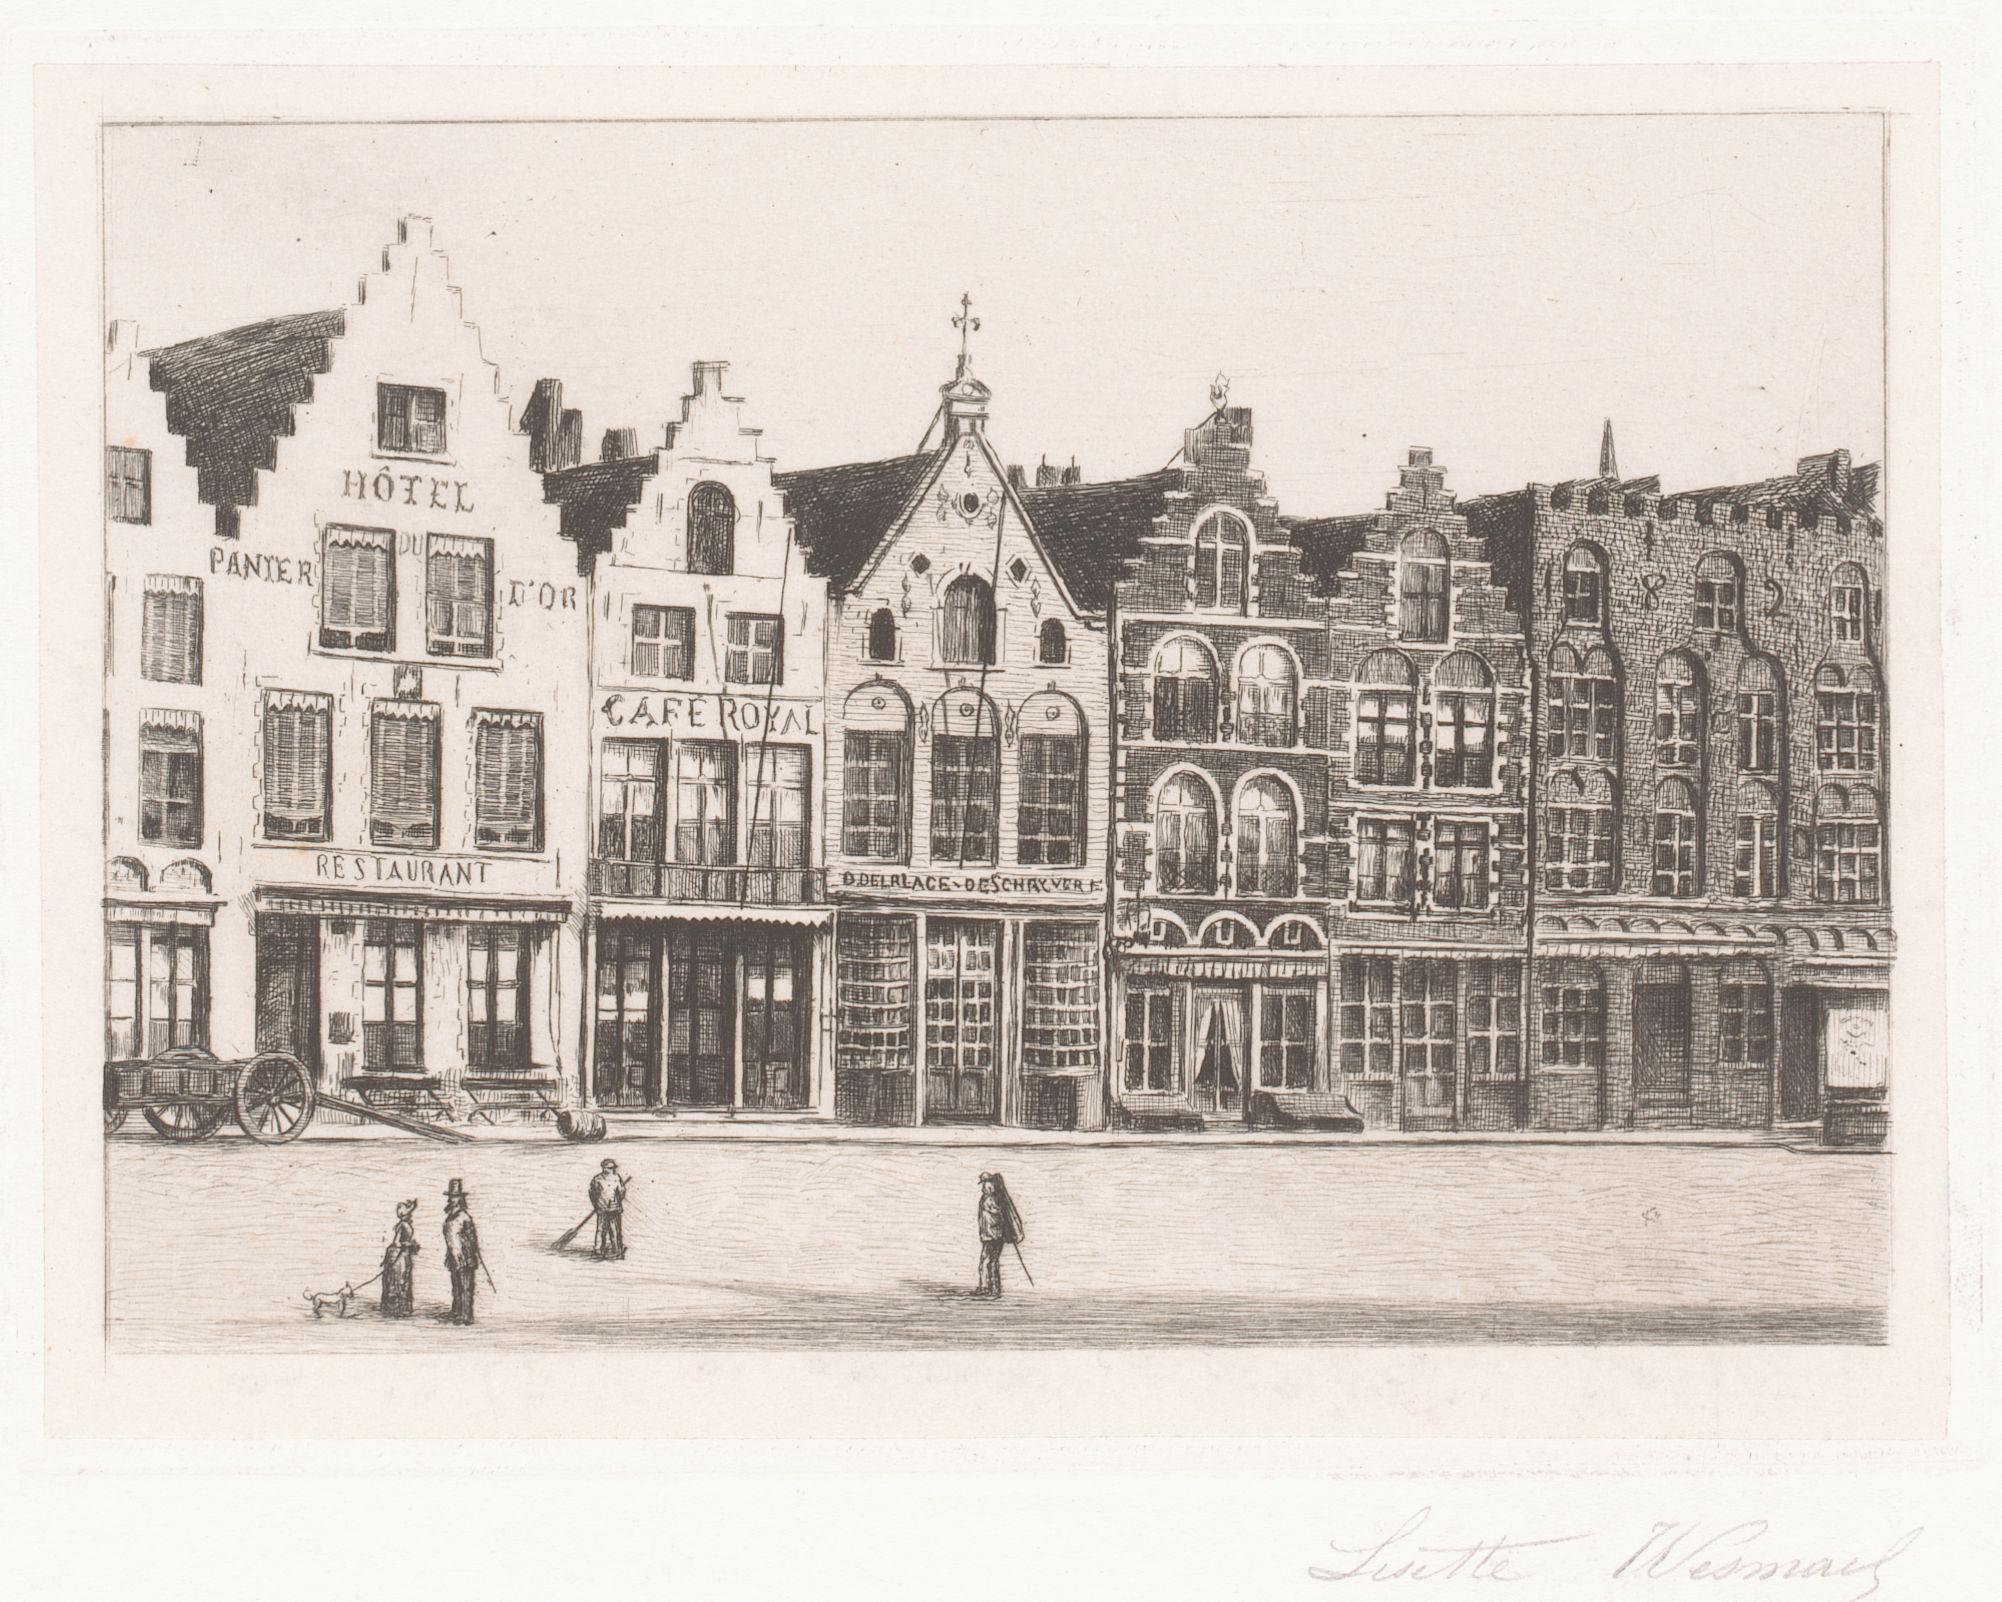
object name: print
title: Maisons flamandes de la grand Place de Bruges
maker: lisette wesmael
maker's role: print maker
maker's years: 1861-1953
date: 1884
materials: paper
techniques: etching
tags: village square, place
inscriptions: collector's mark: Lugt 2228